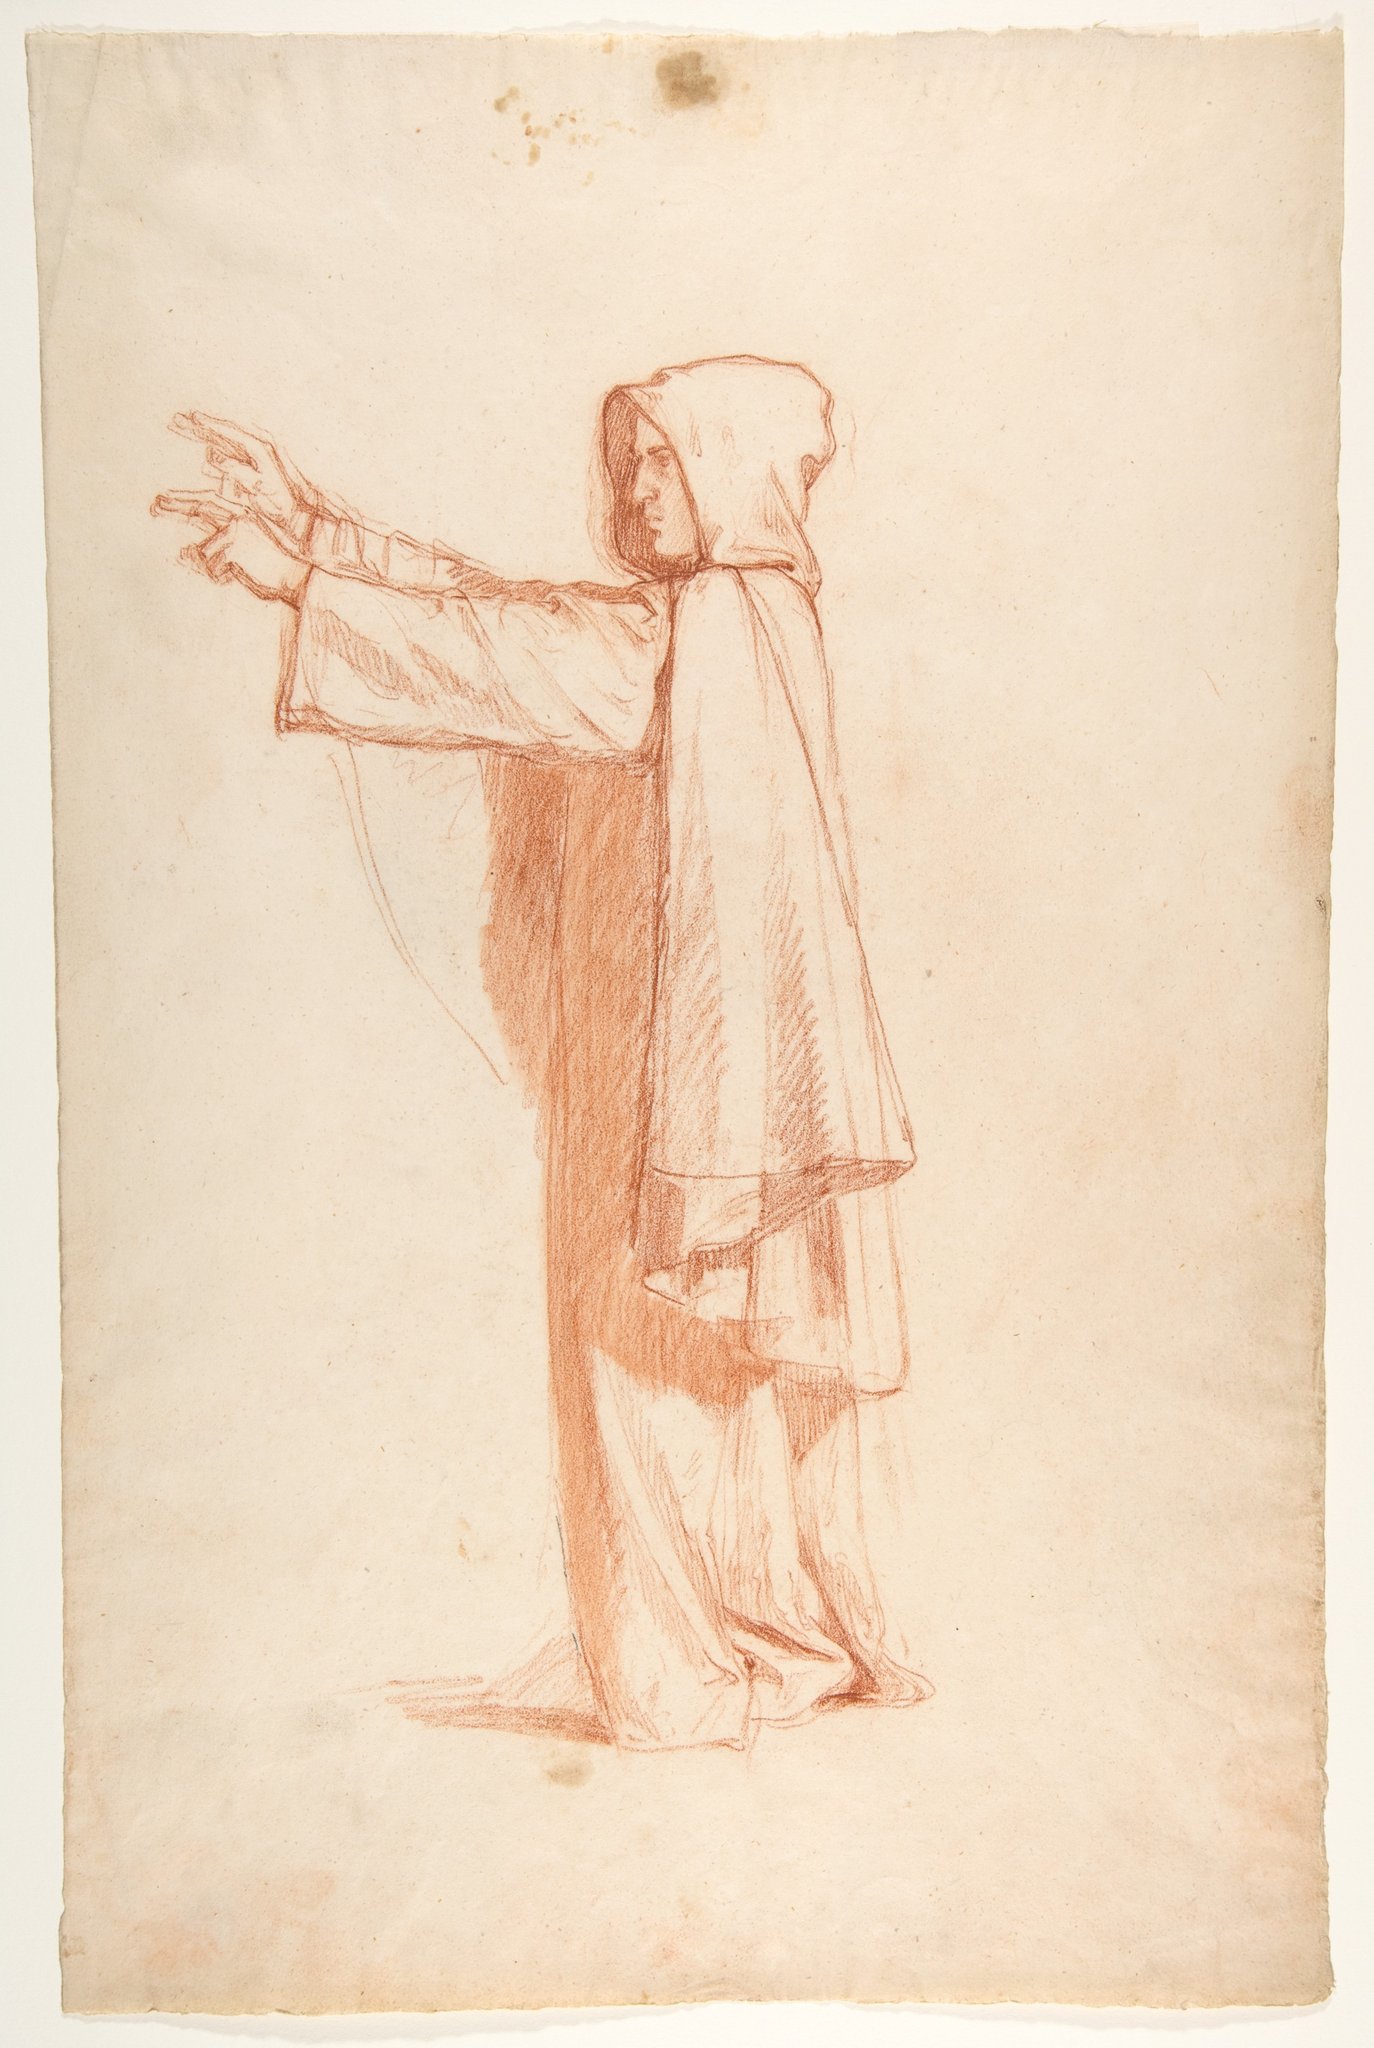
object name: drawing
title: Monk (lower register; study for wall paintings in the Chapel of Saint Remi, Sainte-Clotilde, Paris, 1858)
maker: isidore pils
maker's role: artist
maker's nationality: french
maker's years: 1813-1875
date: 1801-1900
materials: chalk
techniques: stumping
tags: monks